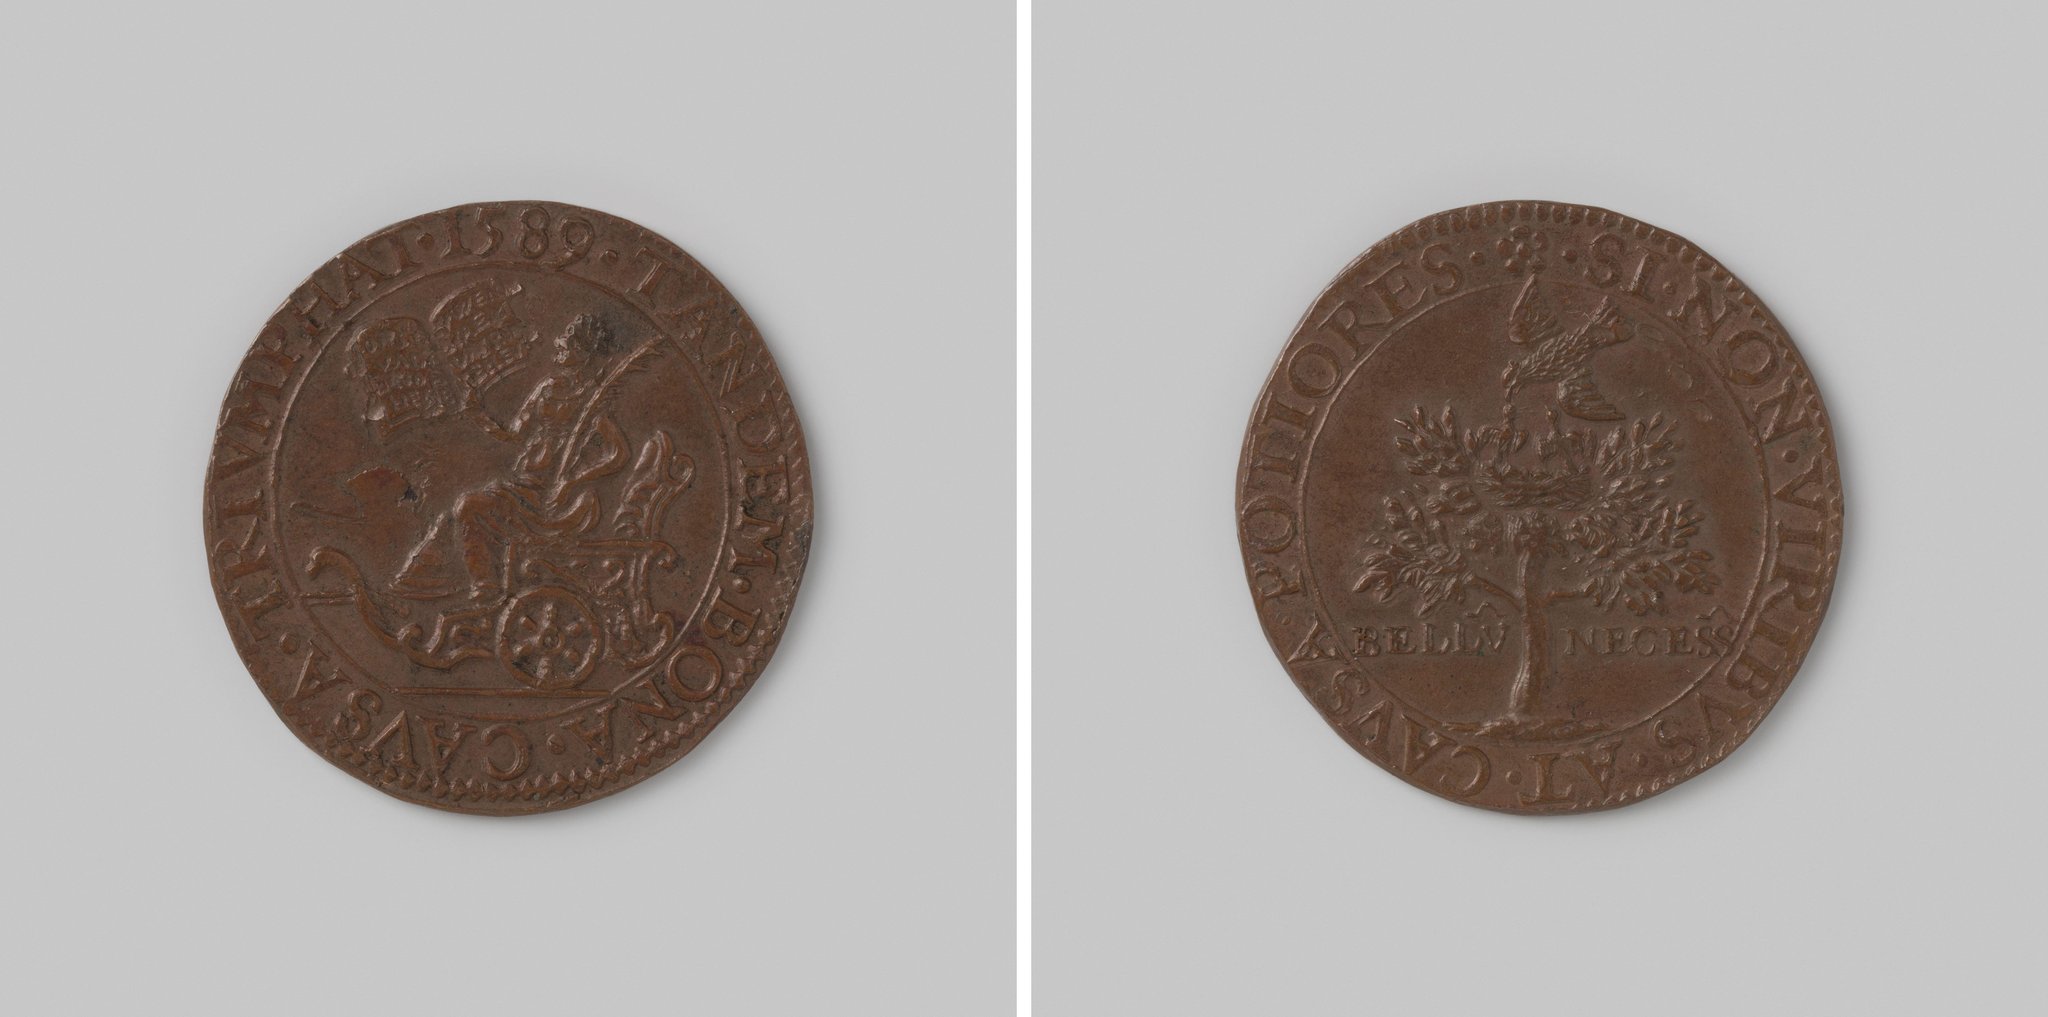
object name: history medal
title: Rekenpenning uit Dordrecht op de dankdag voor het verjagen van de Onoverwinnelijke Vloot 1589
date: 1589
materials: copper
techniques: striking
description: Koperen penning, op de voorzijde een vrouw in zegekar naar links, met gebedenboek en palmtak, met omschrift, op de keerzijde een boom waarin een nest bedreigd door een roofvogel, met tekst in het veld en omschrift.